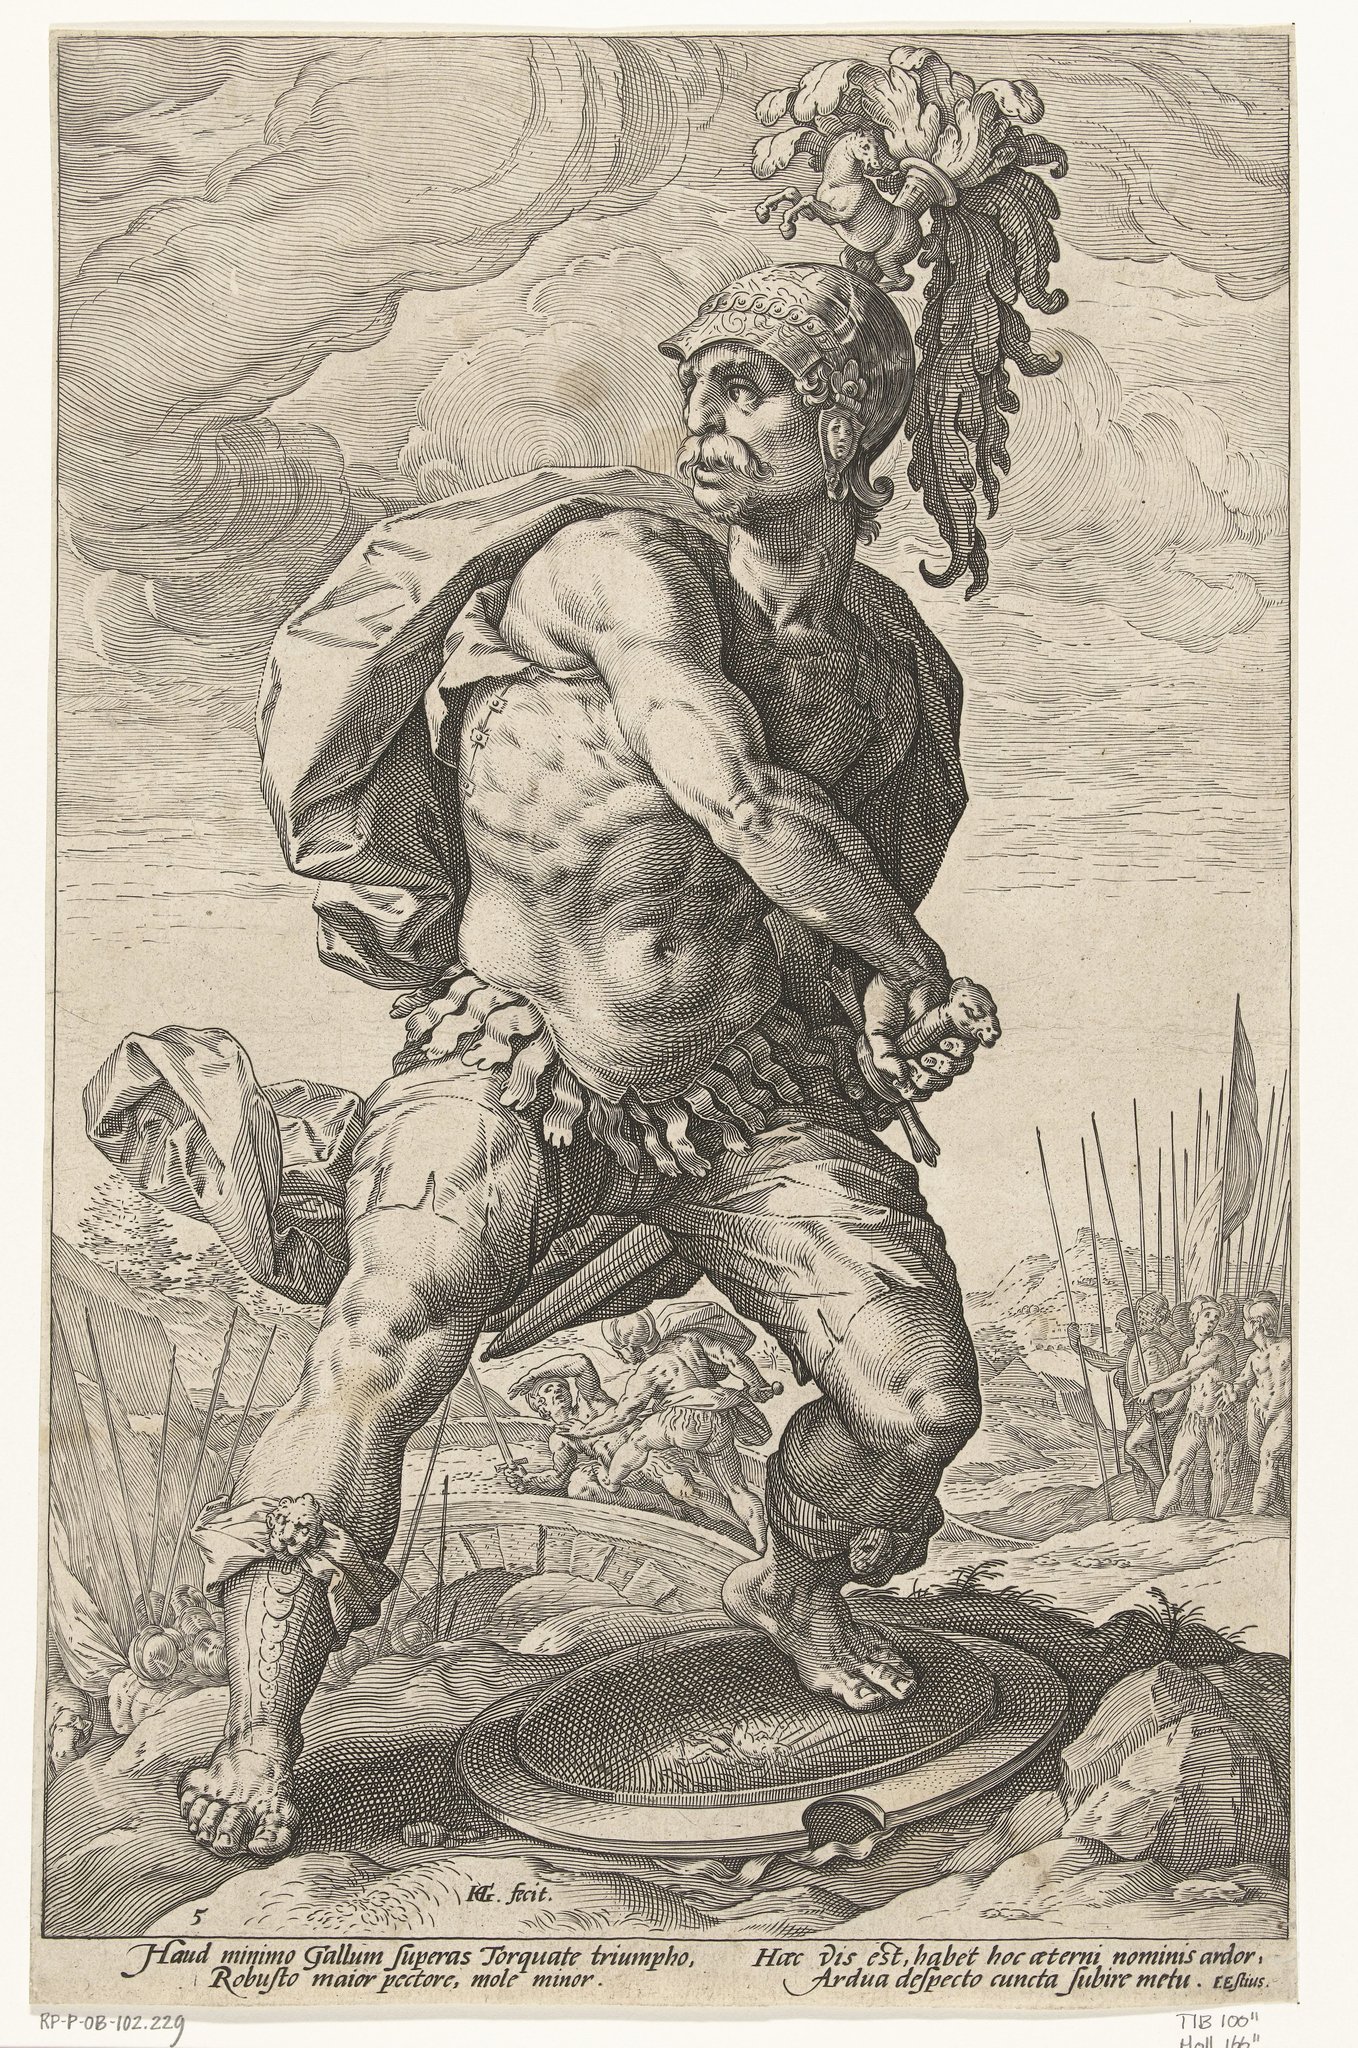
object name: print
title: Titus Manlius Torquatus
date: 1586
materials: paper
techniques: engraving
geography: haarlem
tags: titus manlius torquatus defeats in single combat a gigantic gaul and takes from him his golden neck-chain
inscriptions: collector's mark: Lugt 2228a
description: De held Titus Manlius Torquatus ten voeten uit, terwijl hij zijn zwaard uit de schede trekt. Op de achtergrond is te zien hoe hij op een brug een Galliër verslaat. Onder de voorstelling twee maal twee versregels in Latijn.